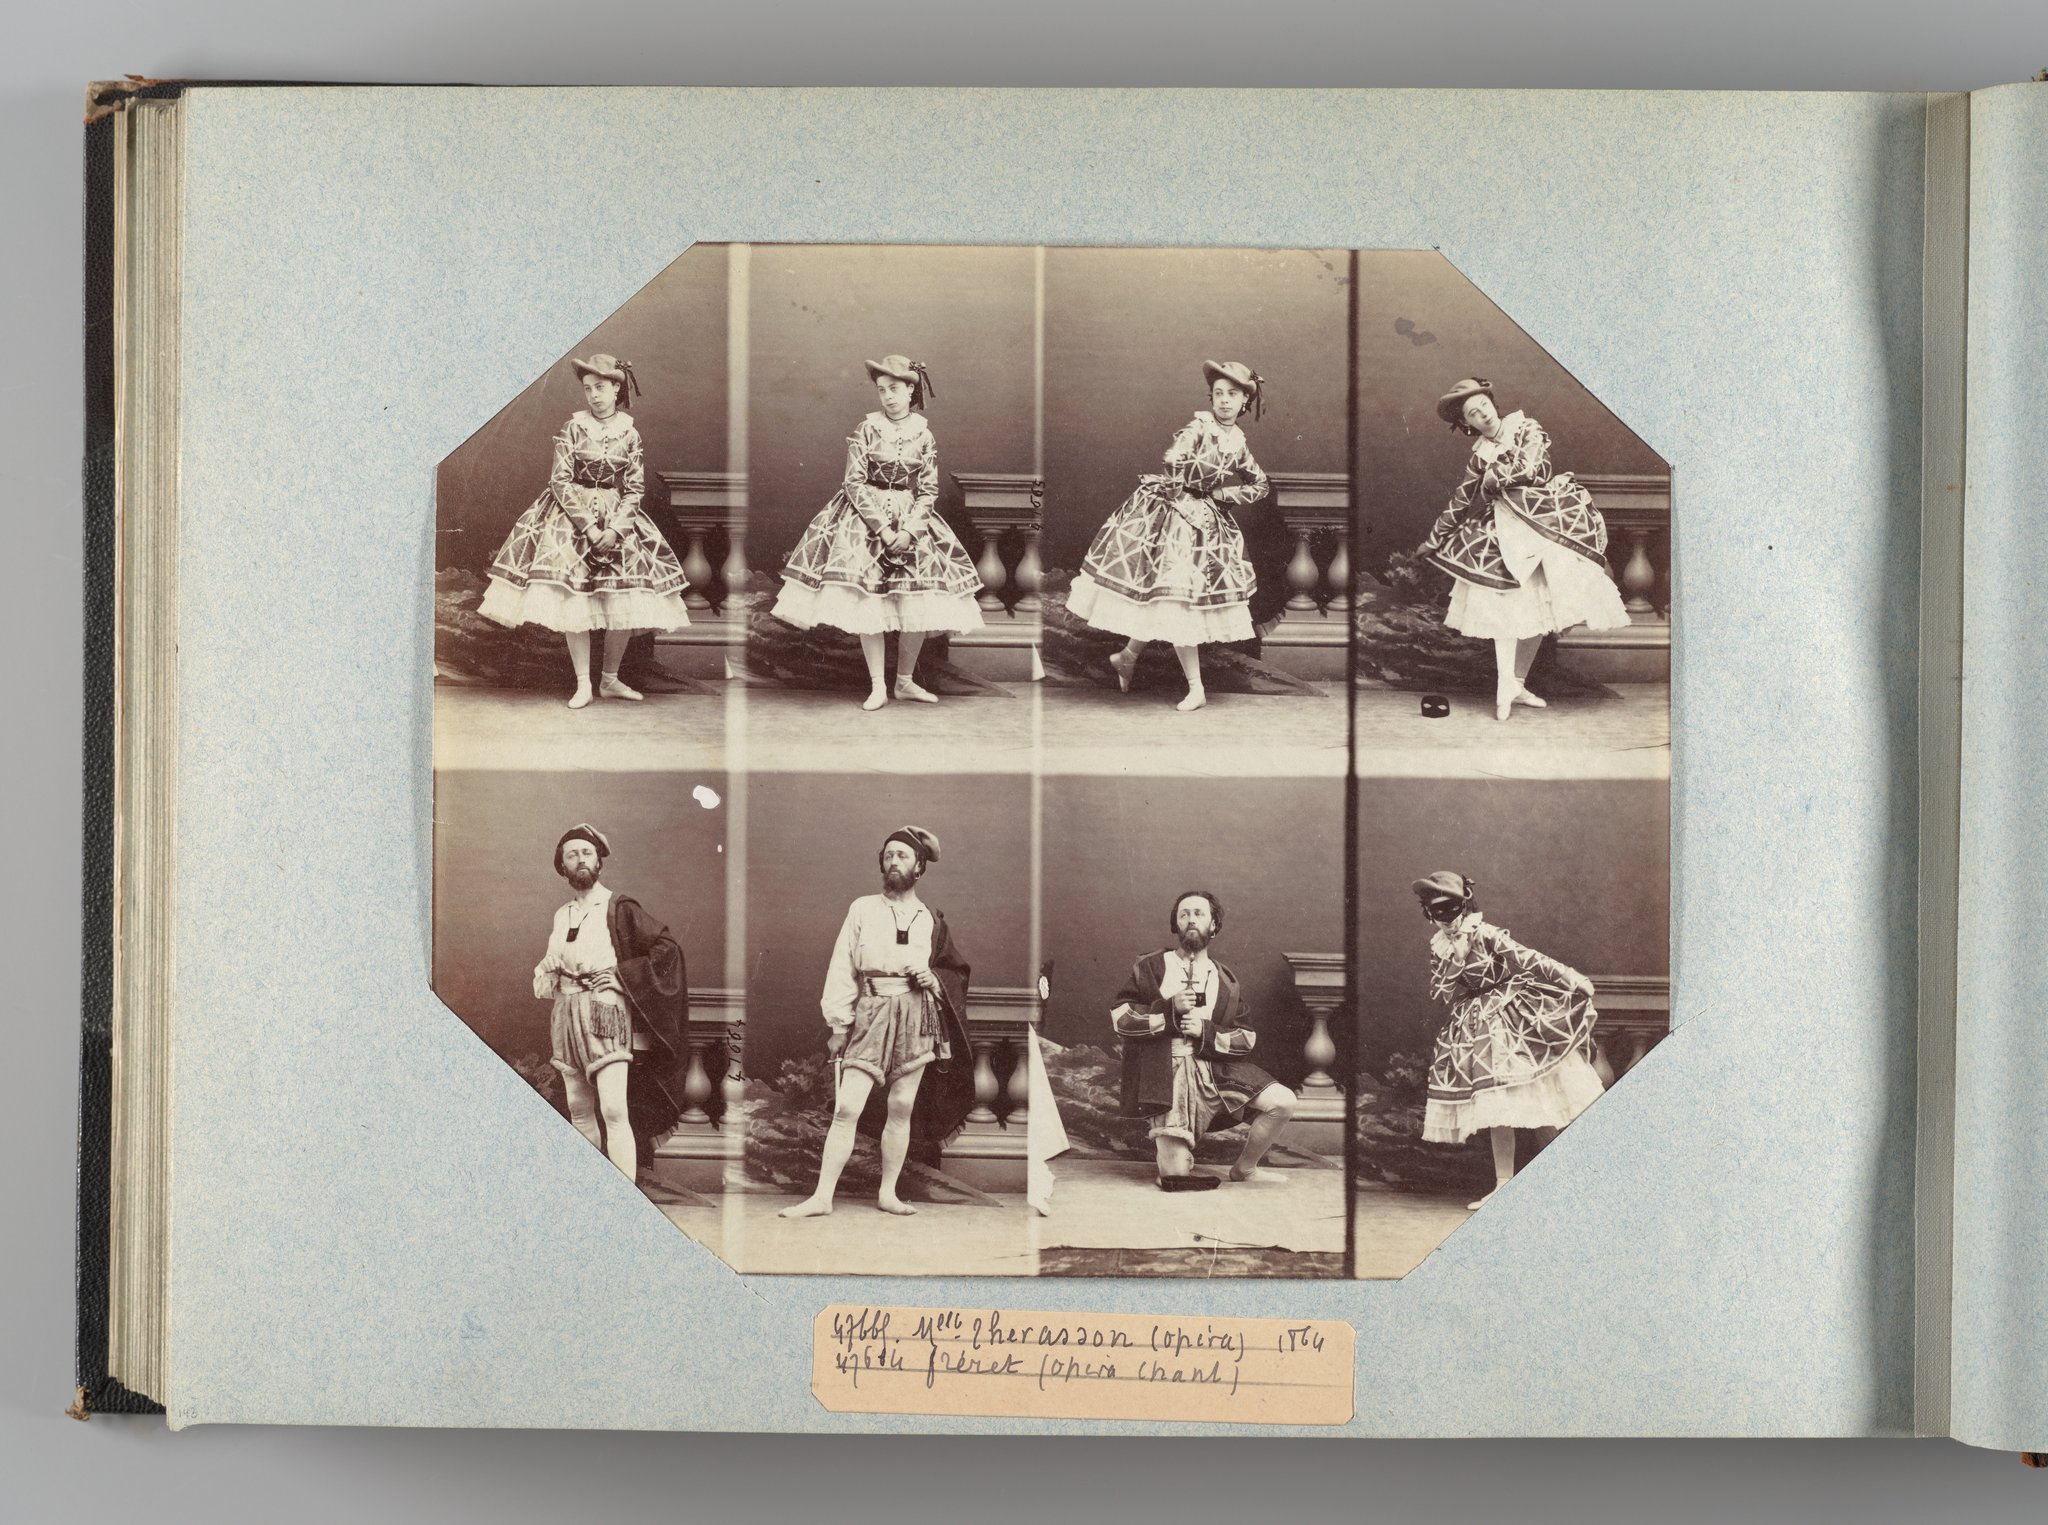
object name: photograph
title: Mlle Therasson [?]; Fréret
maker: andré-adolphe-eugène disdéri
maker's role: artist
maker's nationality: french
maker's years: 1819-1889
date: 1864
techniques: albumen silver print, glass negative